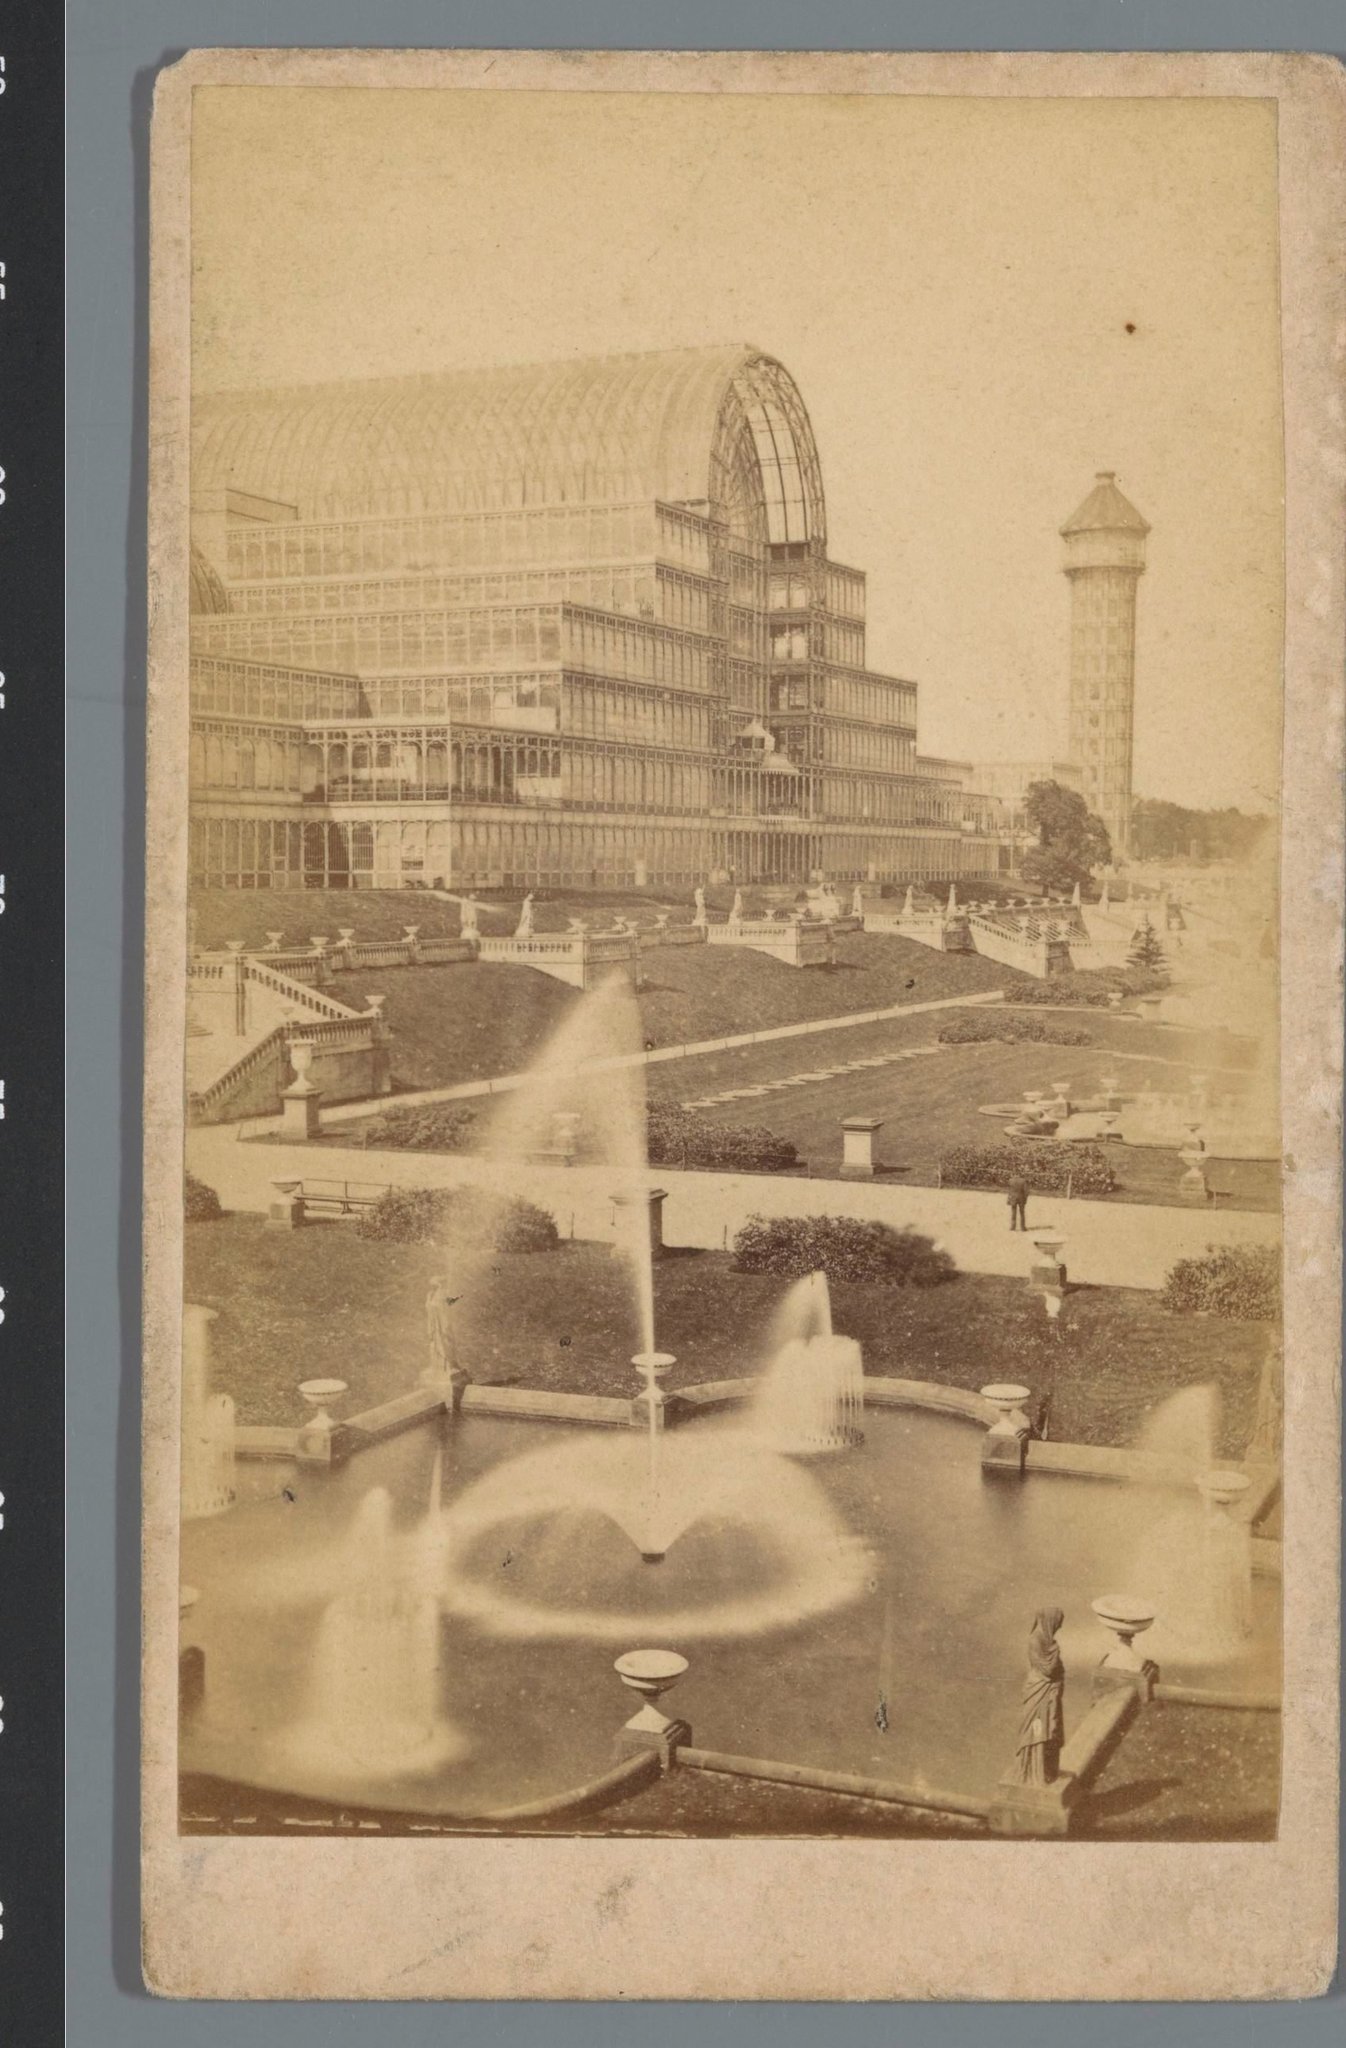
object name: carte de visite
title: Chrystal Palace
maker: Anonymous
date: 1851-1860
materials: cardboard, paper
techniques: albumen print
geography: london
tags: world fair, world exhibition, exterior ~ representation of a building, public gardens, park